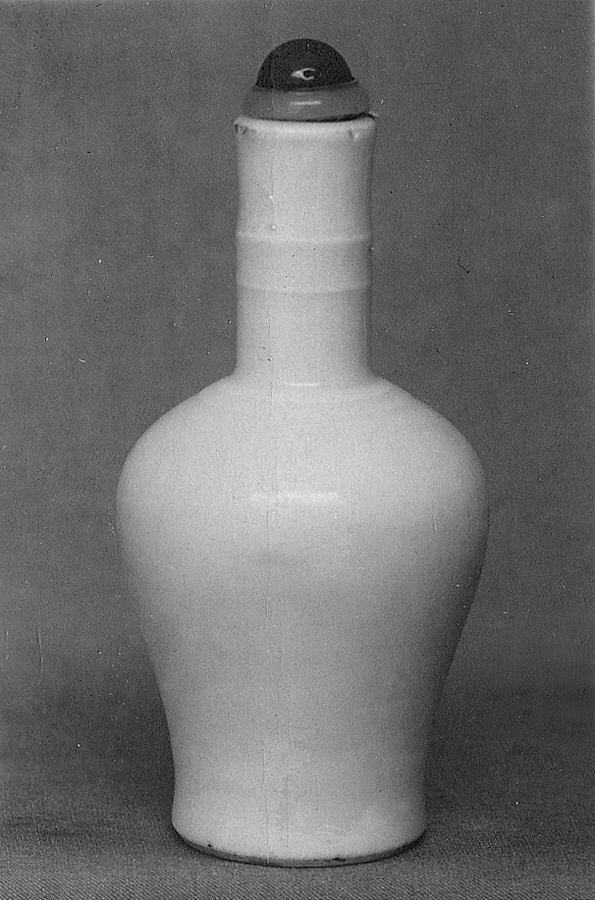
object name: snuff bottle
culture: chinese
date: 1736-1795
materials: porcelain